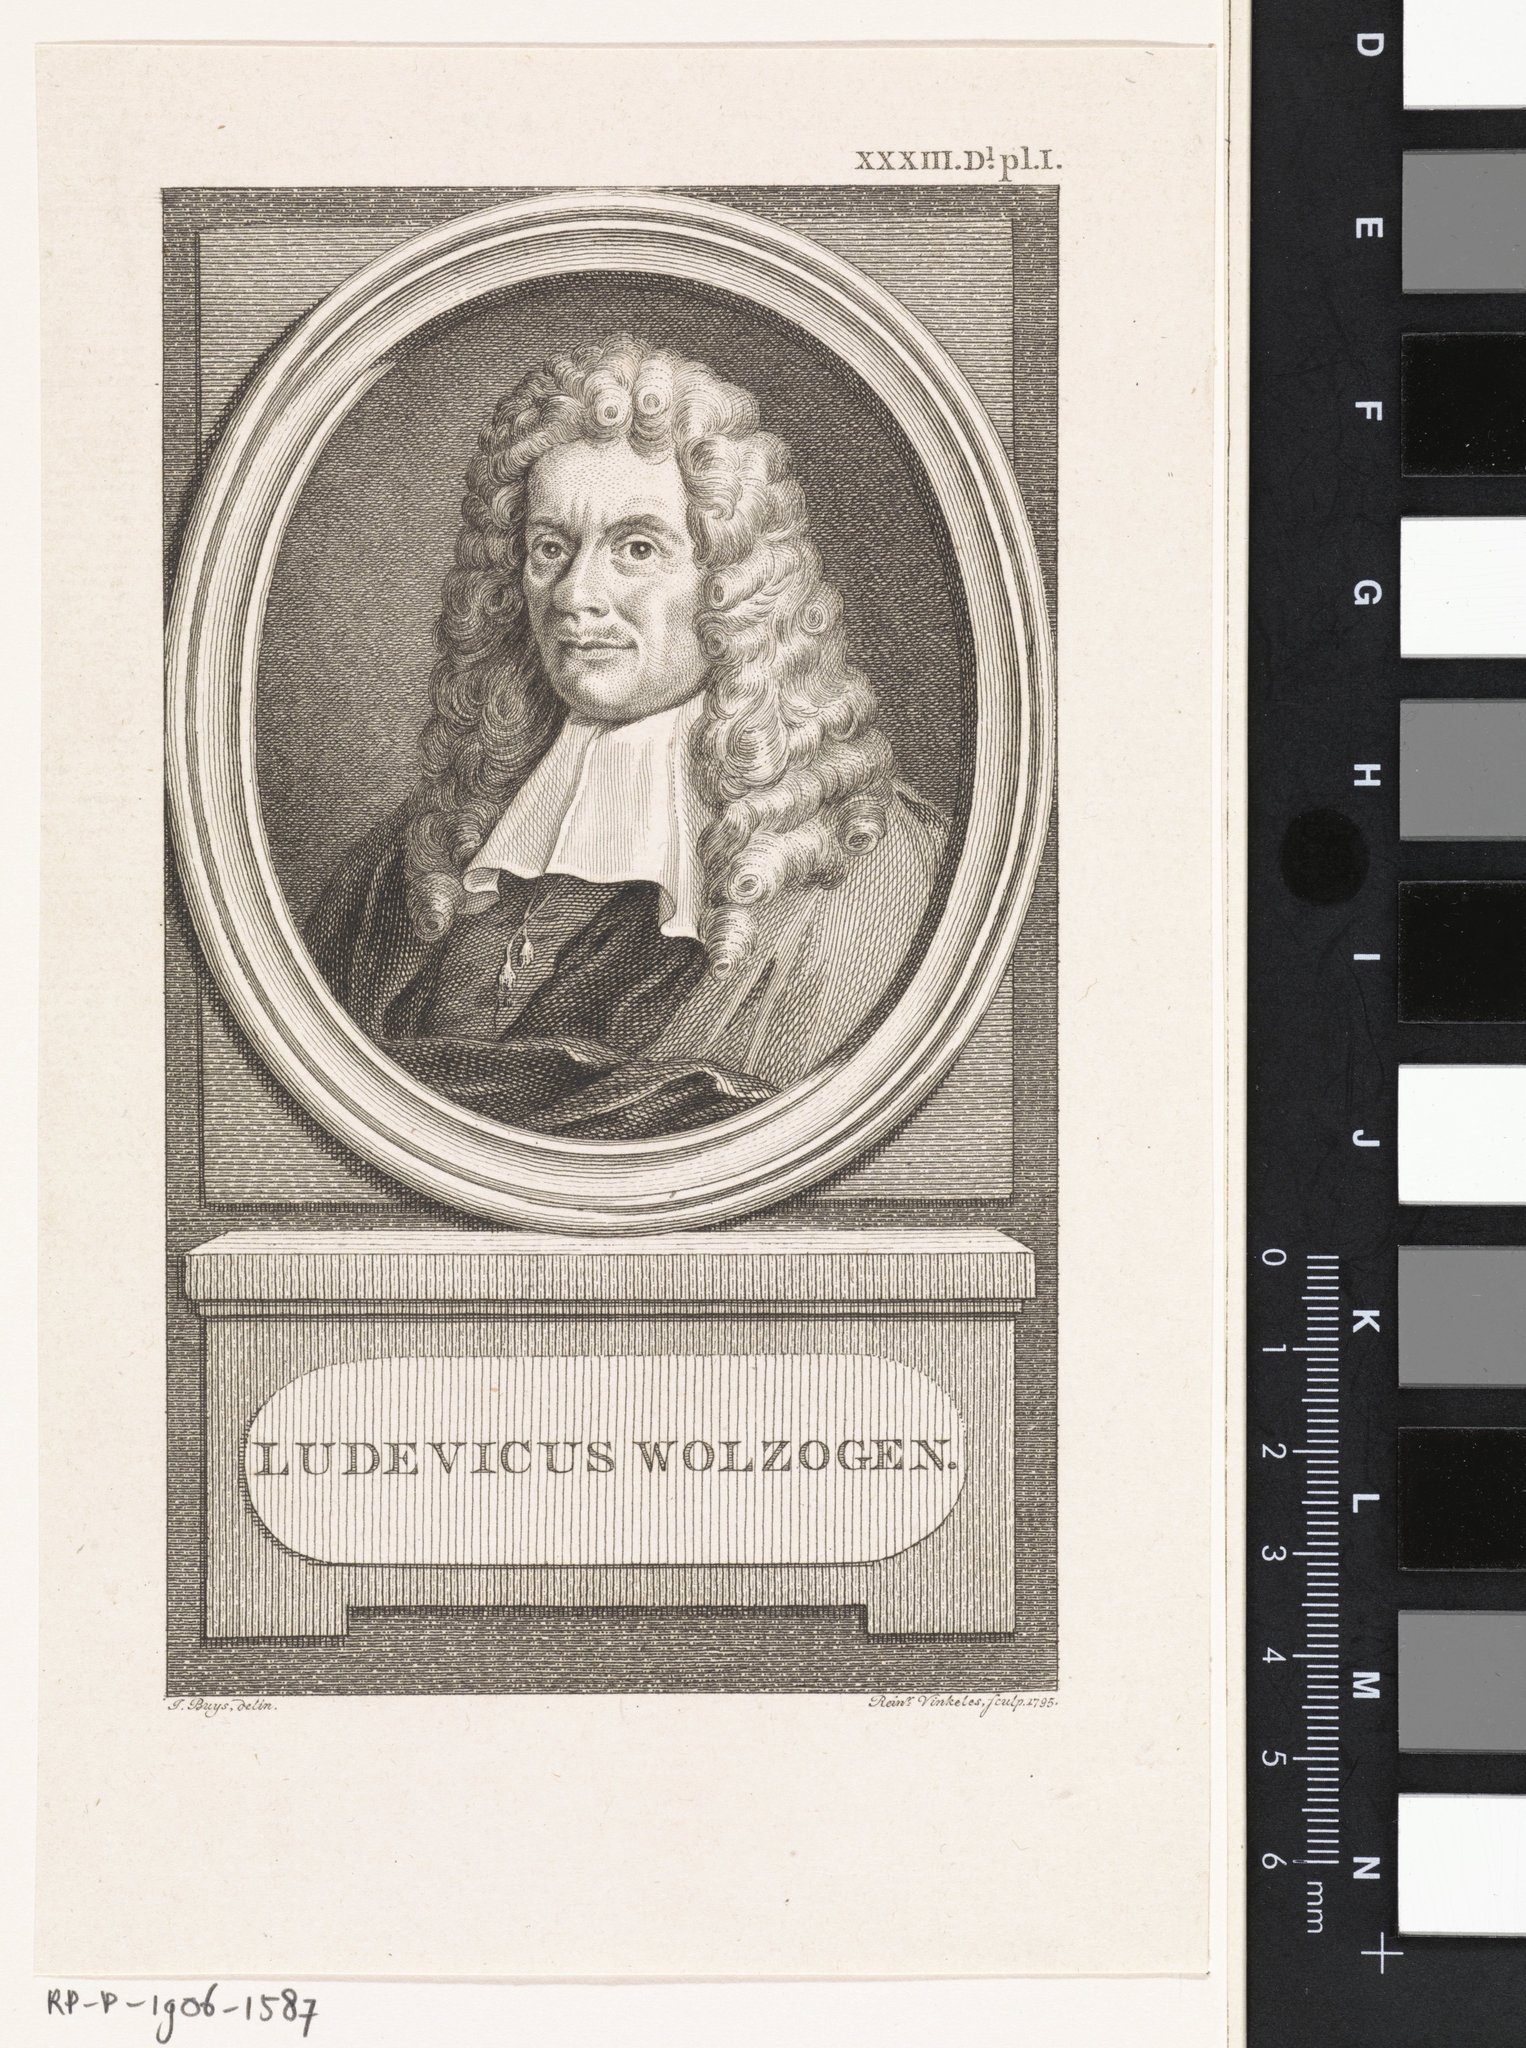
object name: book illustration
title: Portret van Ludovicus Wolzogen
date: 1795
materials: paper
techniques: engraving, etching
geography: amsterdam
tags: amersfoort, theoloog, hoogleraar, ludovicus wolzogen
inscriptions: collector's mark: Lugt 2228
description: Prent gebruikt als boekillustratie in: Kok, Jacobus. Vaderlandsch woordenboek : met kaarten, plaaten en pourtraitten. Amsterdam: Johannes Allart, 1785-1796. Deel XXXIII.